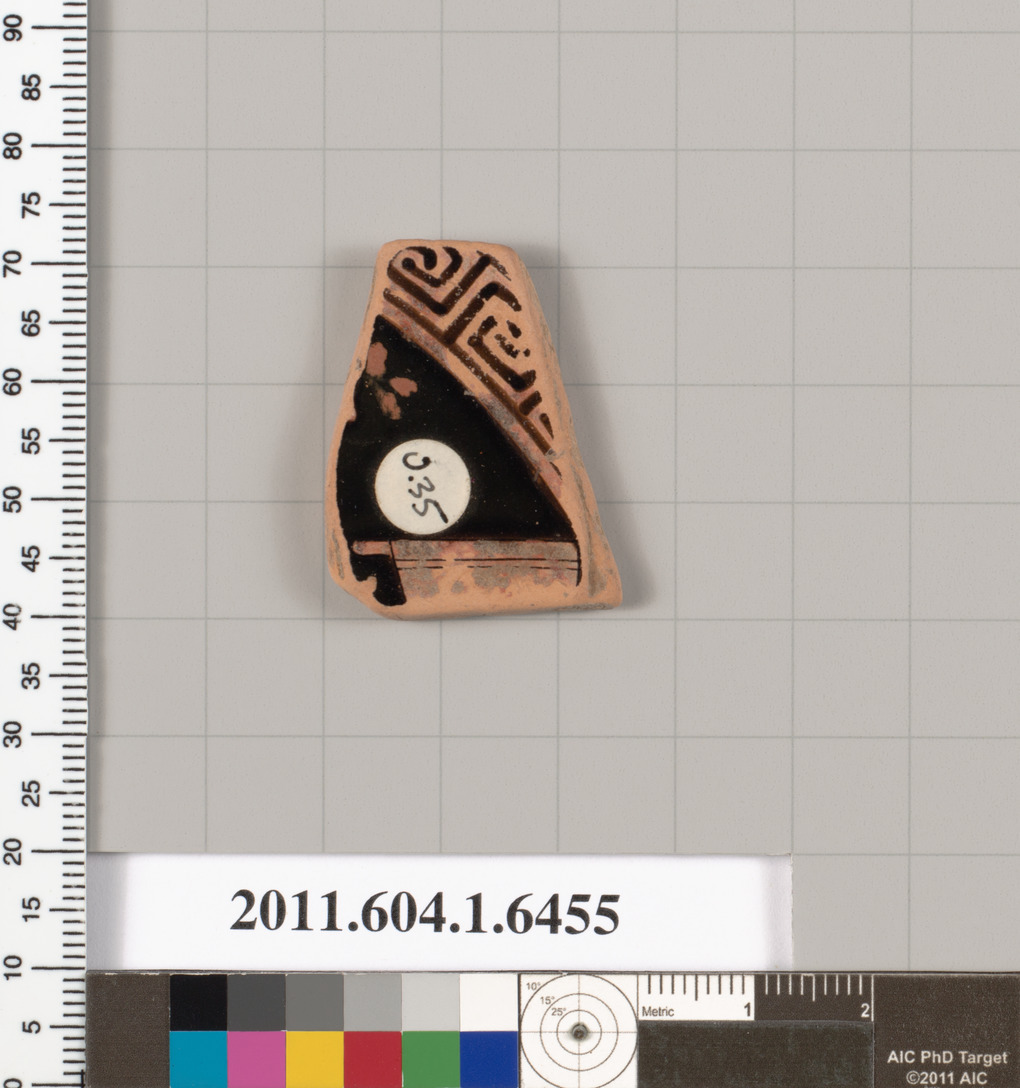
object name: kylix fragment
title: Terracotta fragment of a kylix (drinking cup)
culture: greek, attic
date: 490-480 BCE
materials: terracotta